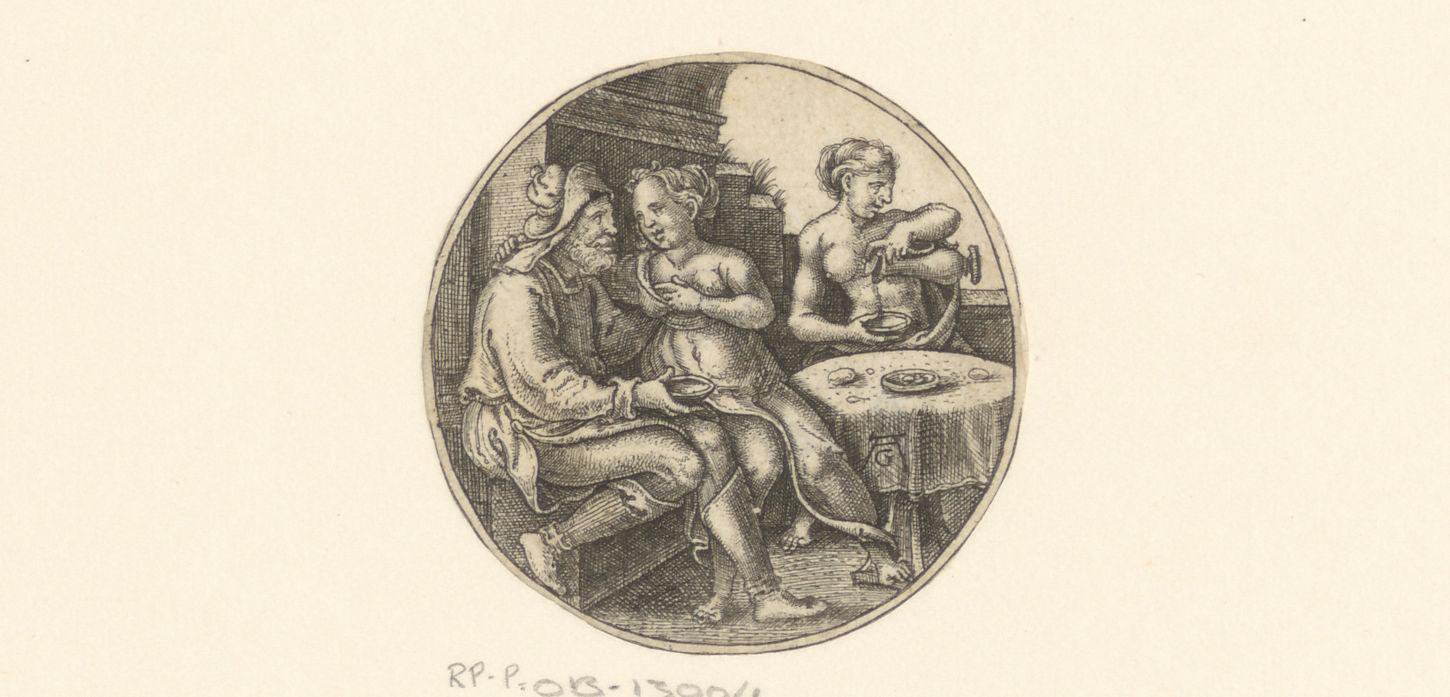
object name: print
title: Lot en zijn dochters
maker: Anonymous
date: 1525-1600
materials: paper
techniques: engraving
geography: germany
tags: lot's daughters make their father drunk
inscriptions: collector's mark: Lugt 2228